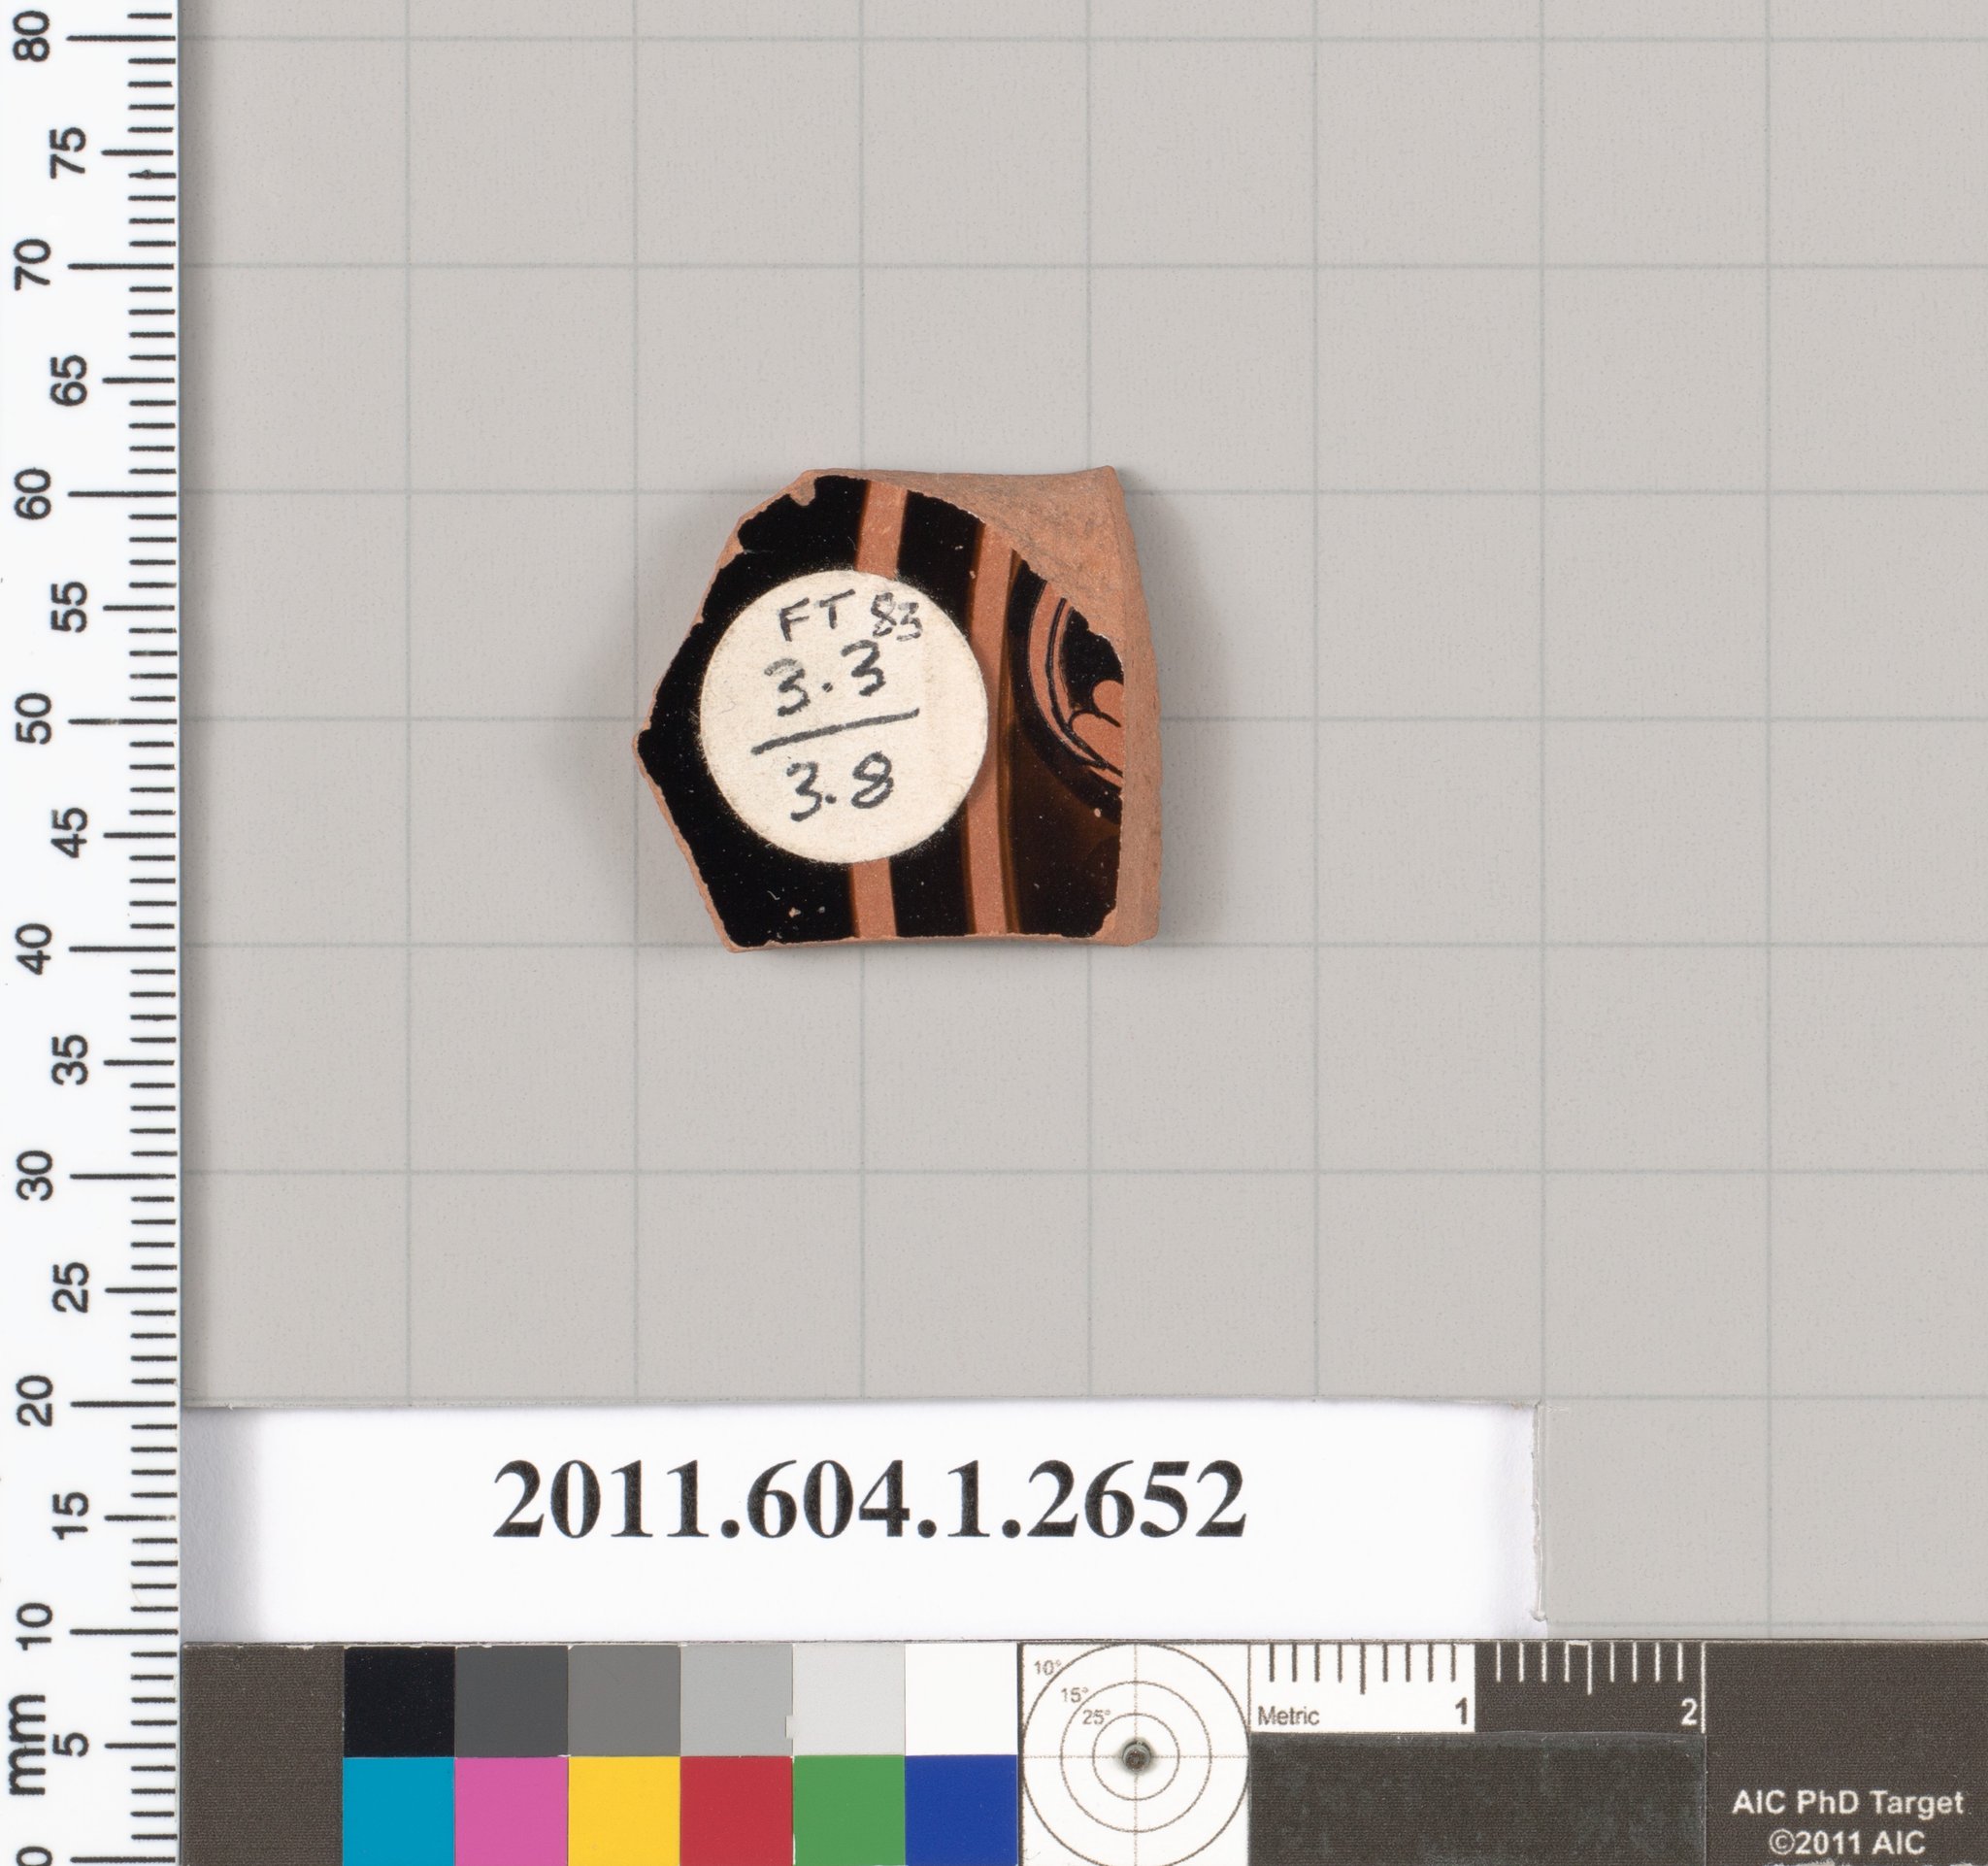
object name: kylix fragment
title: Terracotta fragment of a kylix (drinking cup)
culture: greek, attic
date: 500-480 BCE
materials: terracotta